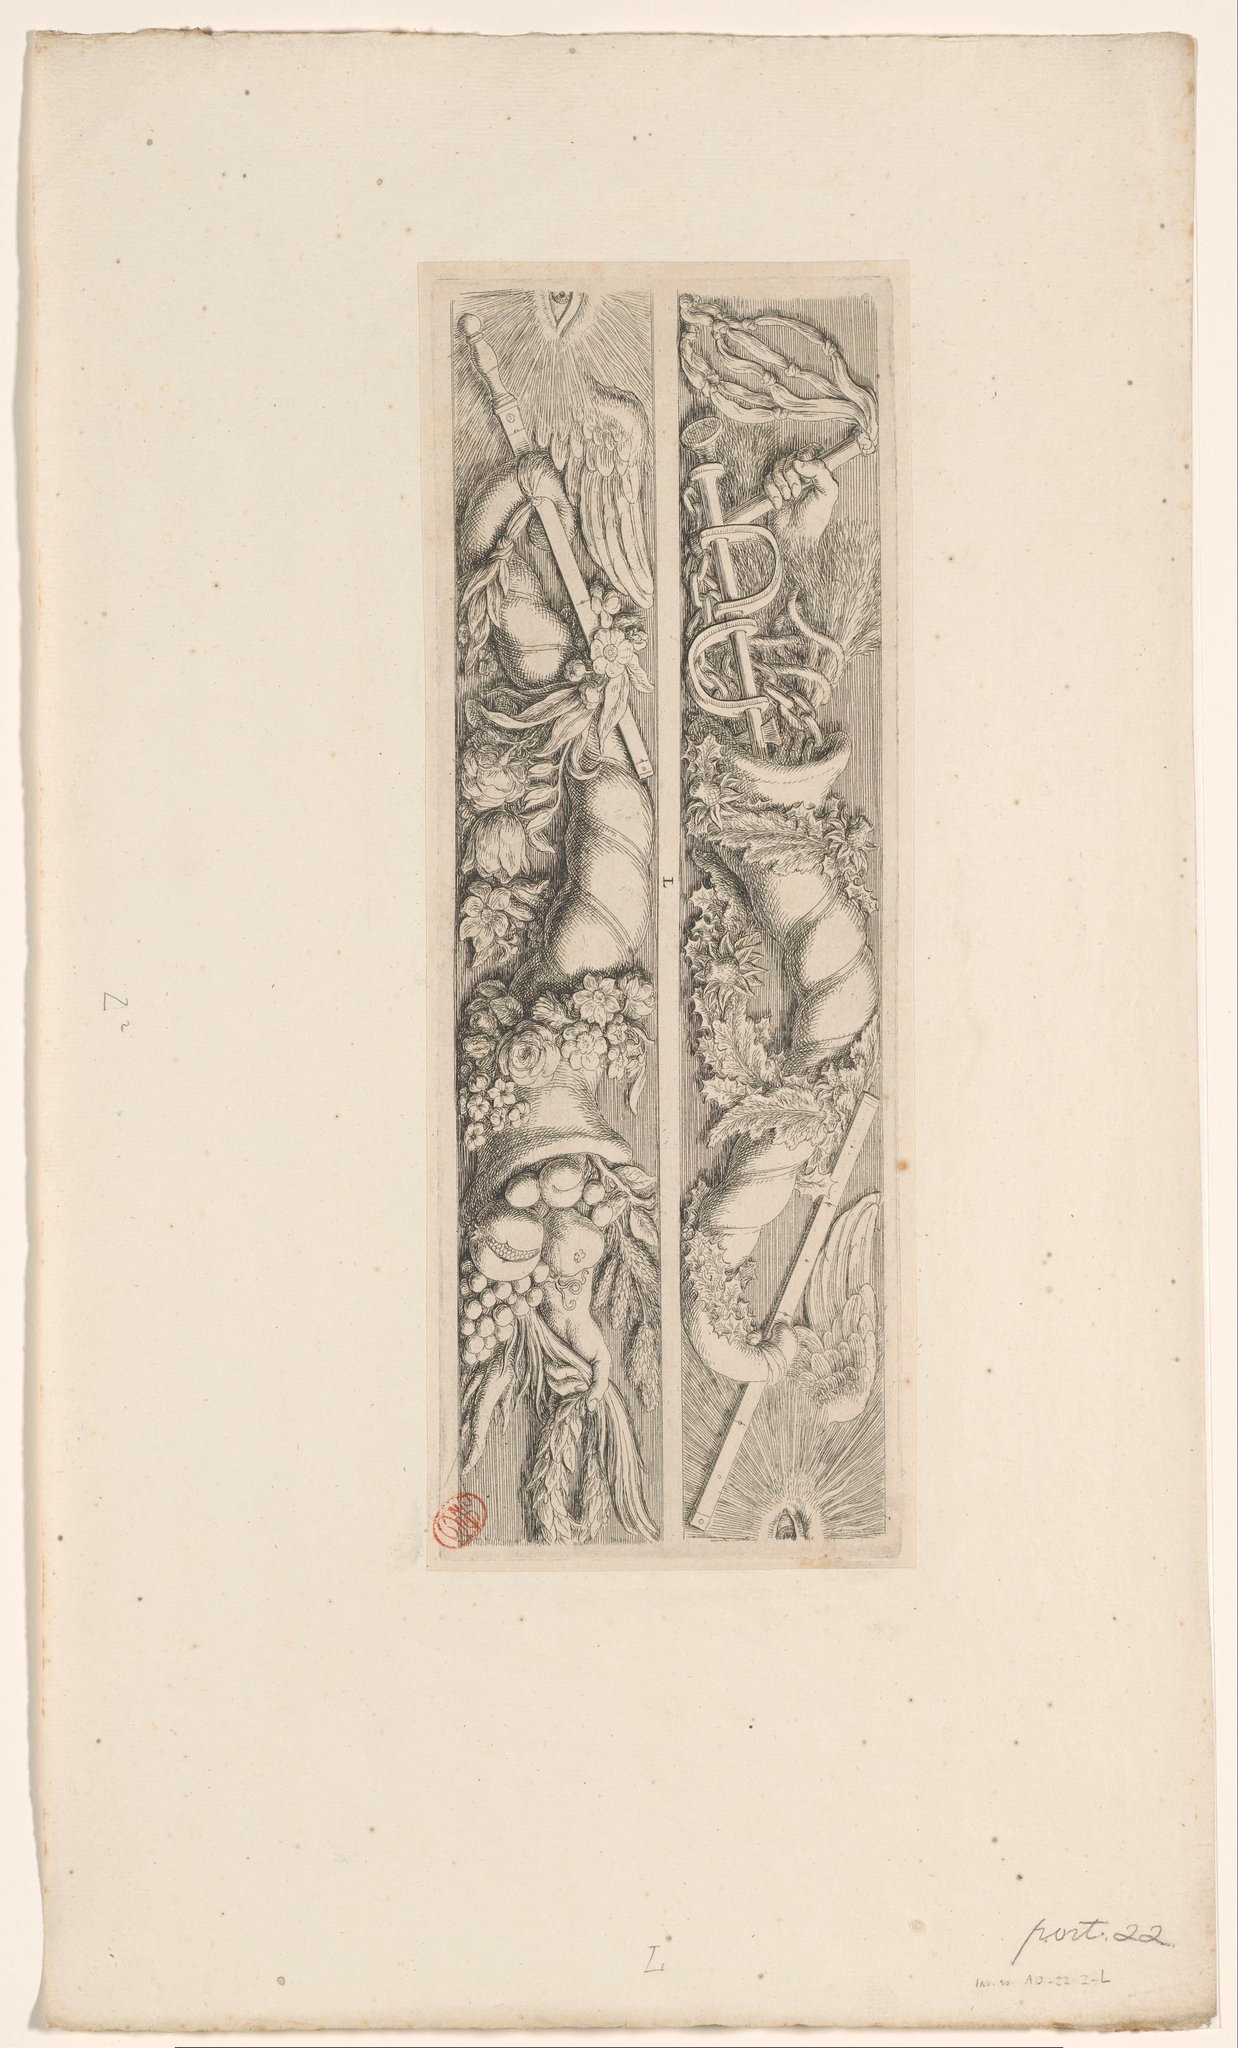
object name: print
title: Fries boven ingang van Schepenzaal aan westzijde van Burgerzaal in het Stadhuis op de Dam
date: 1663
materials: paper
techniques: engraving, etching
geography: amsterdam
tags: 'cornucopia', horn of plenty, measuring-instruments (with name), law and jurisprudence (+ handcuffs, fetters), the all-seeing eye, triangle with eye ~ symbol of god the father, criminal law; punishment, instruments of torture, execution or punishment, rewarding goodness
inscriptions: collector's mark: Lugt 195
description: Prent gebruikt in: Secunca pars Praecipuarum effigierum ac ornamentorum amplissime Curiae Amstelrodamensis maiori ex parte in cadido marmore effectorum per Artum Quellinium eiusdem Civitatis Statuarium / Het tweede deel Van de voornaemste Statuen ende Cieraten van 't konst-rijcke Stadt-huys van Amstelredam 'tmeeste in Marmer gemaeckt door Artus Quellinus Beelthouwer der voorseyde Stadt. Amsterdam: Artus Quellinus (I), 1663. Zie RP-P-AO-22-2-1 voor bijhorende titelpagina. Zie RP-P-AO-22-2-2 voor bijhorend register. Zie RP-P-AO-22-2A, RP-P-AO-22-2B, RP-P-AO-22-2C-1, RP-P-AO-22-2C-2, RP-P-AO-22-2C-3, RP-P-AO-22-2C-4, RP-P-AO-22-2D-1, RP-P-AO-22-2D-2, RP-P-AO-22-2D-3, RP-P-AO-22-2E-1, RP-P-AO-22-2E-2, RP-P-AO-22-2E-3, RP-P-AO-22-2E-4, RP-P-AO-22-2F-1, RP-P-AO-22-2F-2, RP-P-AO-22-2F-3, RP-P-AO-22-2G, RP-P-AO-22-2H, RP-P-AO-22-2I, RP-P-AO-22-2K, RP-P-AO-22-2M, RP-P-AO-22-2N, RP-P-AO-22-2O-1, RP-P-AO-22-2O-2, RP-P-AO-22-2O-3, RP-P-AO-22-2O-4, RP-P-AO-22-2O-5, RP-P-AO-22-2O-6, RP-P-AO-22-2O-7, RP-P-AO-22-2P-1, RP-P-AO-22-2P-2, RP-P-AO-22-2Q-1, RP-P-AO-22-2Q-2, RP-P-AO-22-2Q-3, RP-P-AO-22-2R-1, RP-P-AO-22-2R-2, RP-P-AO-22-2R-3, RP-P-AO-22-2S, RP-P-AO-22-2T-1, RP-P-AO-22-2T-2, RP-P-AO-22-2T-3, RP-P-AO-22-2T-4, RP-P-AO-22-2V-1, RP-P-AO-22-2V-2, RP-P-AO-22-2W-1, RP-P-AO-22-2W-2, RP-P-AO-22-2X-1, RP-P-AO-22-2X-2 en RP-P-AO-22-2X-3 voor andere prenten uit deze publicatie. Zelfde staat van prent ook gebruikt in: Secunca pars Praecipuarum effigierum ac ornamentorum amplissime Curiae Amstelrodamensis maiori ex parte in cadido marmore effectorum per Artum Quellinium eiusdem Civitatis Statuarium / Het tweede deel Van de voornaemste Statuen ende Cieraten van 't konst-rijcke Stadt-huys van Amstelredam 'tmeeste in Marmer gemaeckt door Artus Quellinus Beelthouwer der voorseyde Stadt. Amsterdam: Frederik de Wit, 1668. Latere staat van prent ook gebruikt in: Architecture peinture et sculpture de la Maison de Ville d'Amsterdam, representee en CIX. figures en taille-douce (…). Amsterdam: David Mortier, 1719. En in: Architecture peinture et sculpture de la Maison de Ville d'Amsterdam, representee en CIX. figures en taille-douce (…). Amsterdam: Gerard Valck, 1719. En in: Bouw schilder en beeldhouwkonst, van het Stadhuis te Amsteldam, vertoont in CIX figuuren (…). Amsterdam: Covens & Mortier & Covens Jr., s.a. (1774-1783).